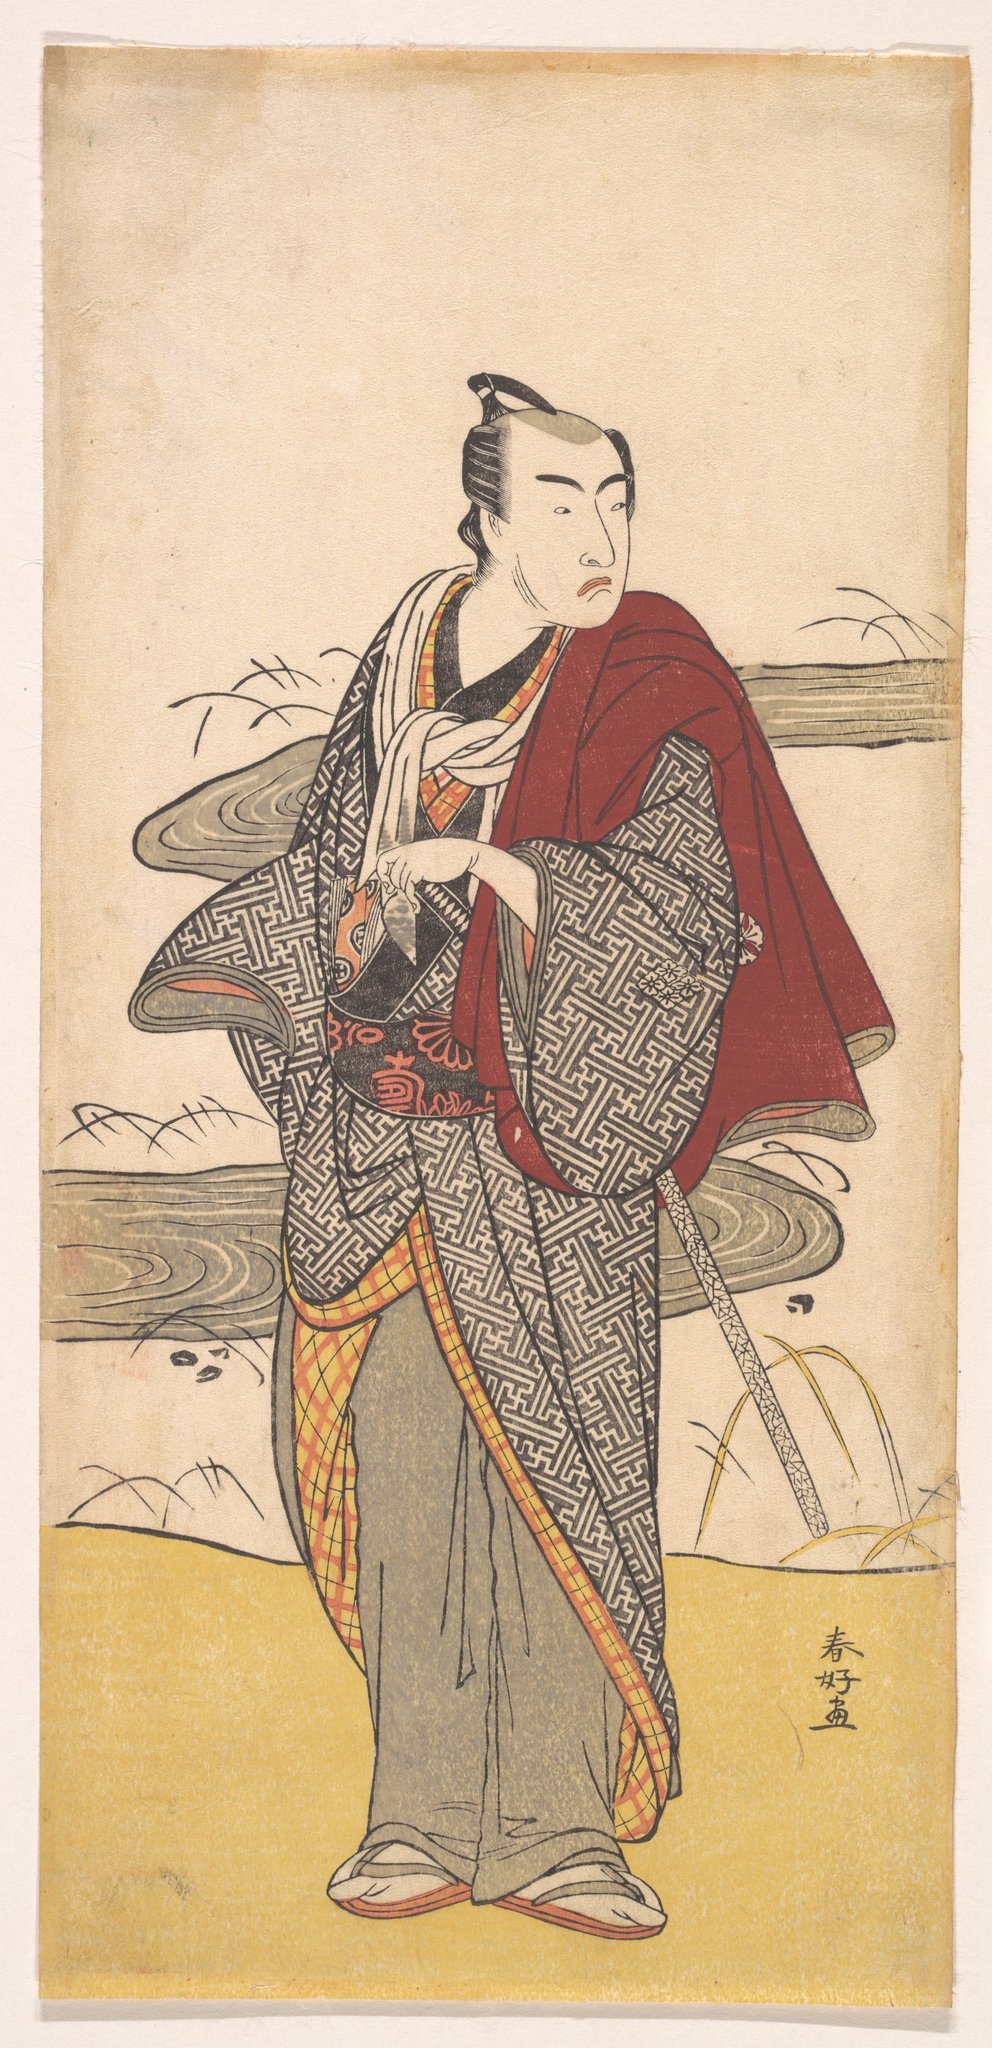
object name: print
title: The Actor Matsumoto Koshiro 4th as a Man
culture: japanese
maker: katsukawa shunkō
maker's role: artist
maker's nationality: japanese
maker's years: 1743-1812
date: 1780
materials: ink, paper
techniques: woodblock print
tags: men,actors